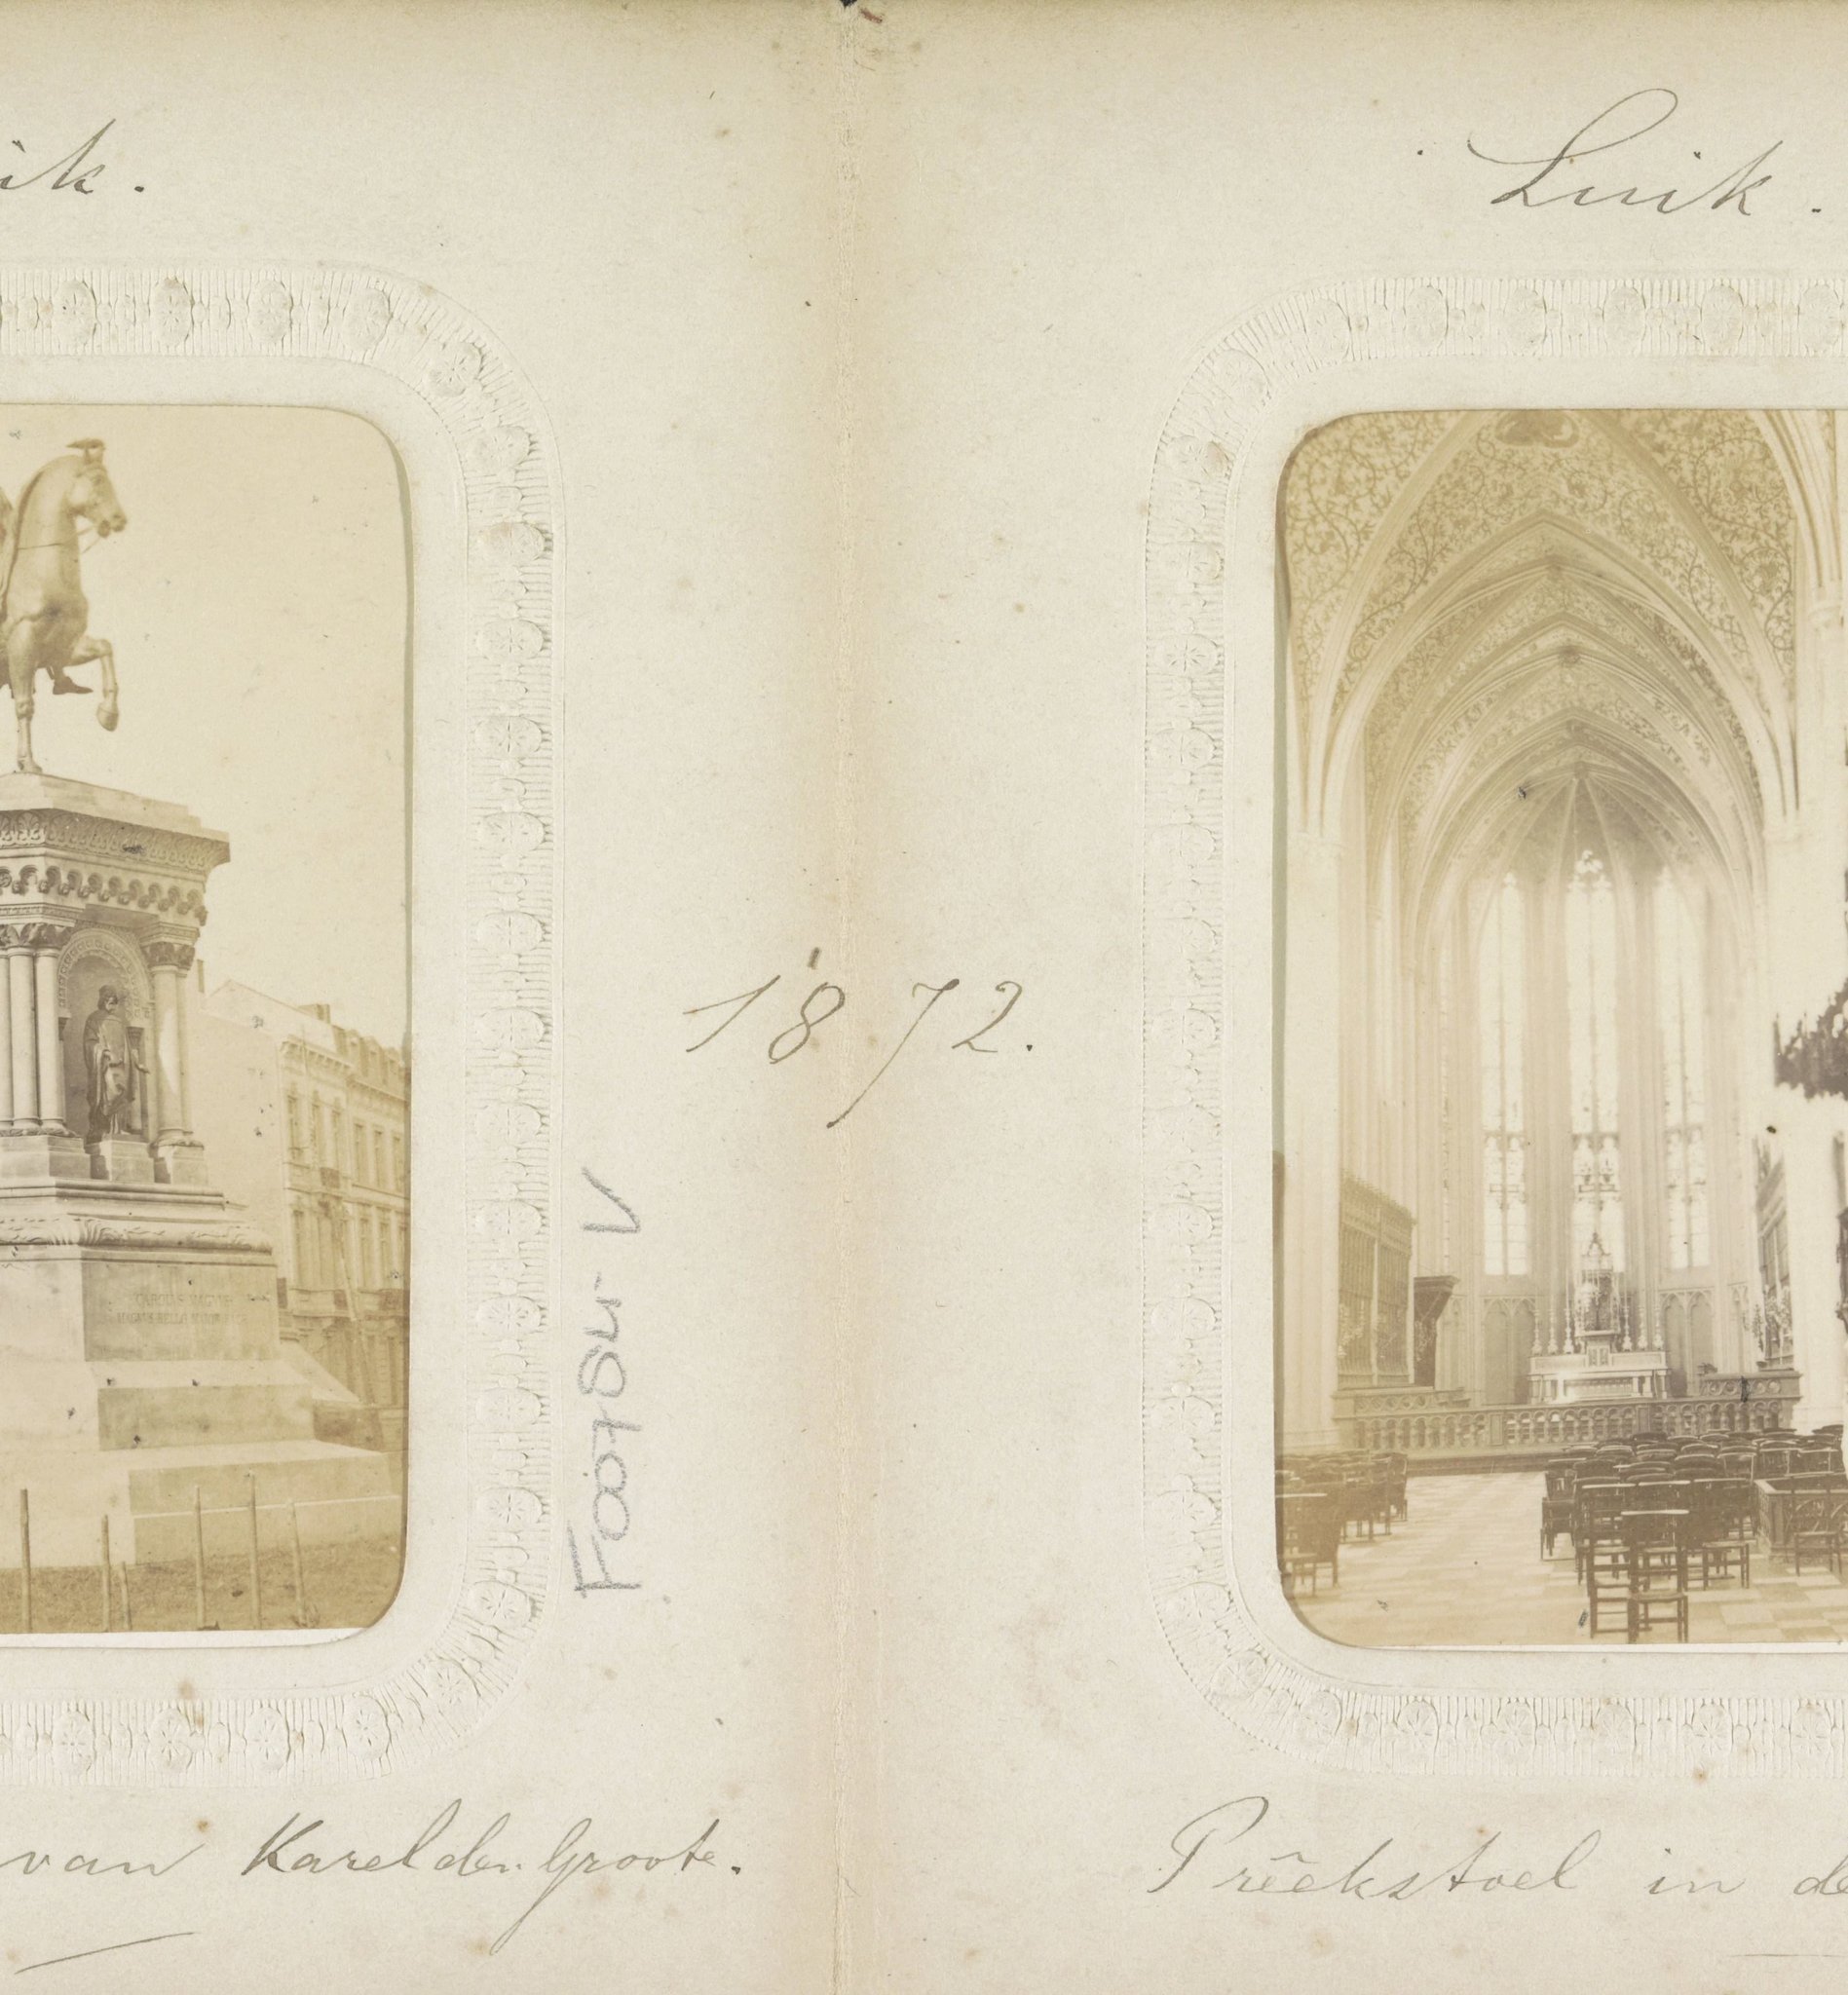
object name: photograph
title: Luik. Standbeeld van Karel der Groote.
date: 1872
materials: cardboard, paper, photographic support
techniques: albumen print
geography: liège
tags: equestrian statue, liège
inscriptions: number: ‘586[...]’, address: ‘Dornach Ht. Rhin’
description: Onderdeel van Fotoalbum met bezienswaardigheden in Nederlandse, Belgische en Duitse steden.